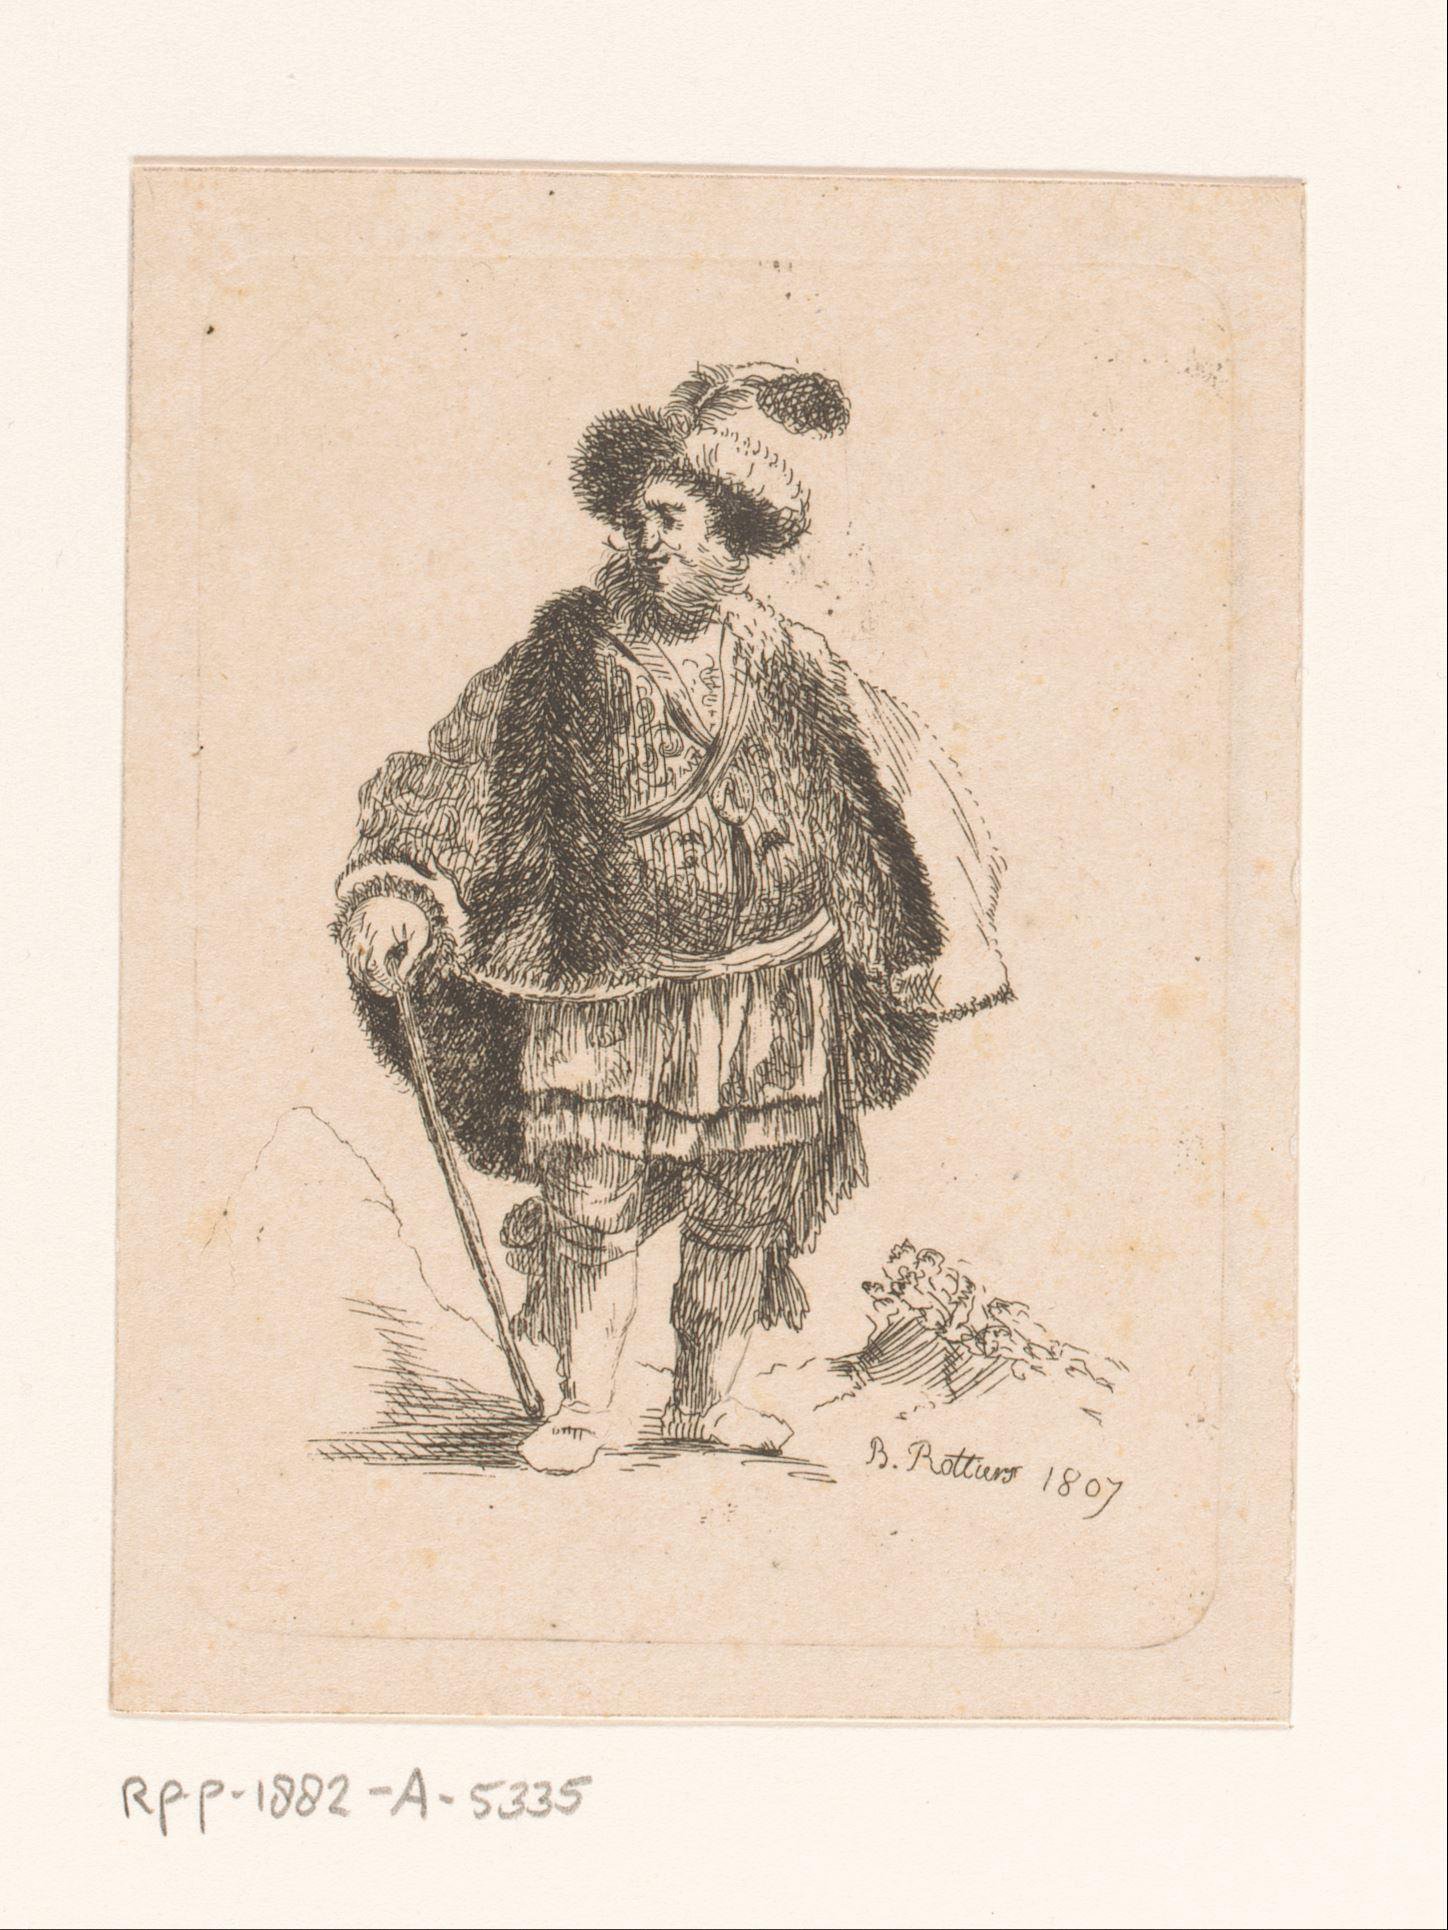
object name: print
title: Man met wandelstok en bontmantel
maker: bernard eugène antoine rottiers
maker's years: 1771-1857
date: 1807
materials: paper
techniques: etching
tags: coat, cape (+ men's clothes), walking-stick, staff, adult man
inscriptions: collector's mark: Lugt 2228